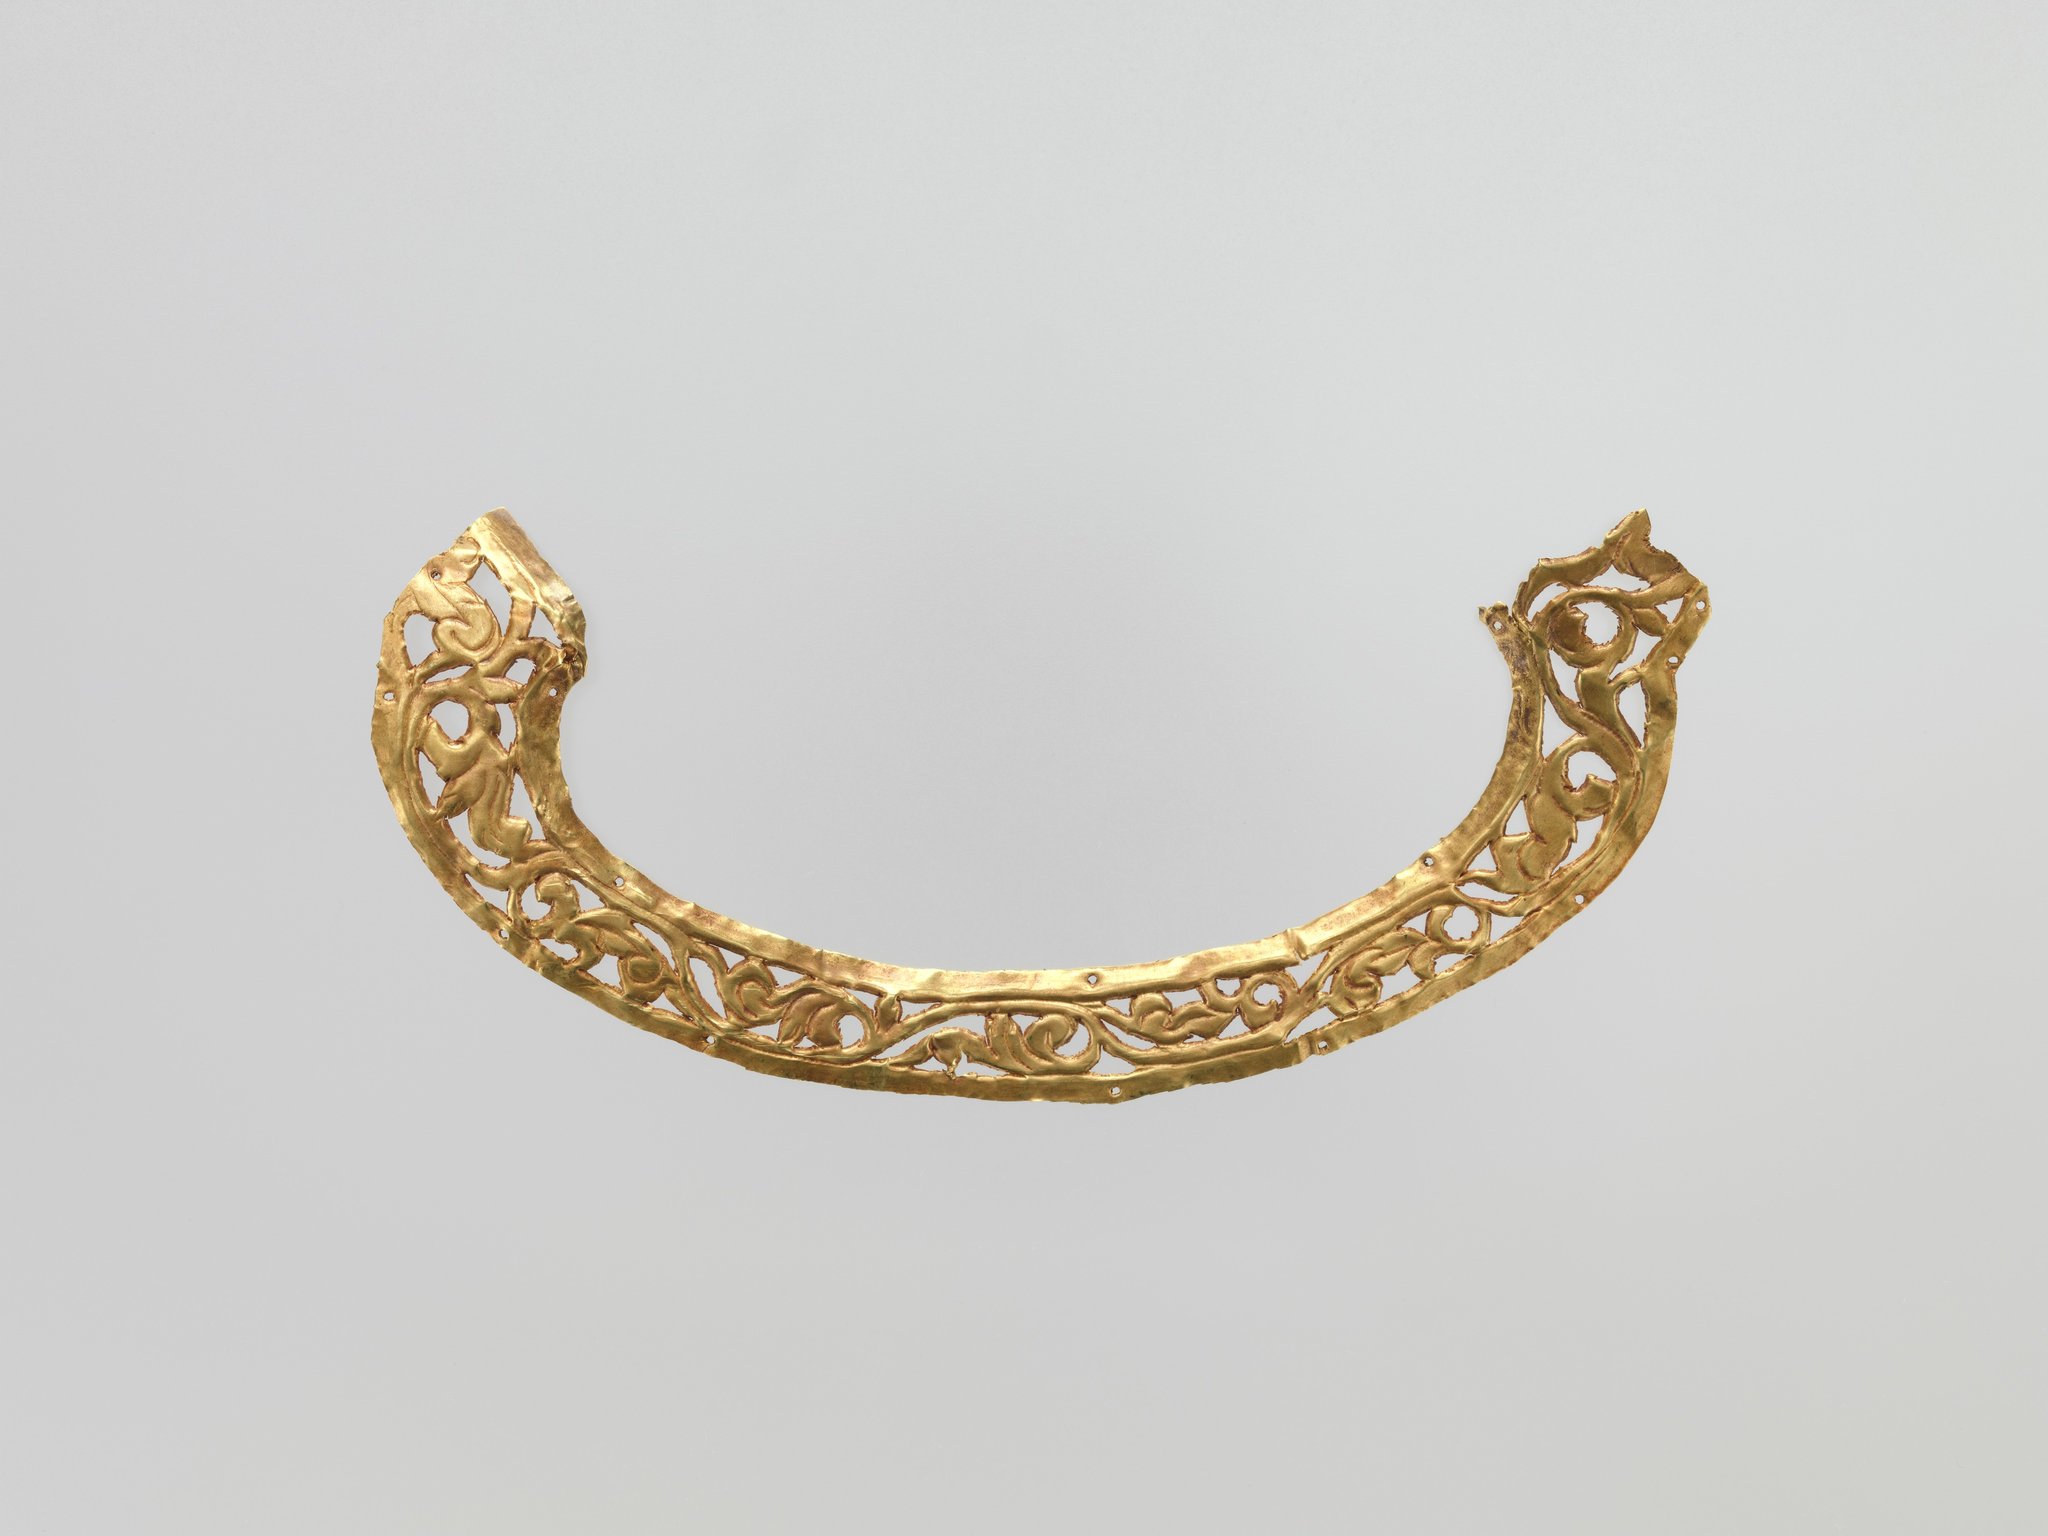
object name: fitting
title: Saddle Pommel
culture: chinese or central asian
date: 601-900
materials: gold